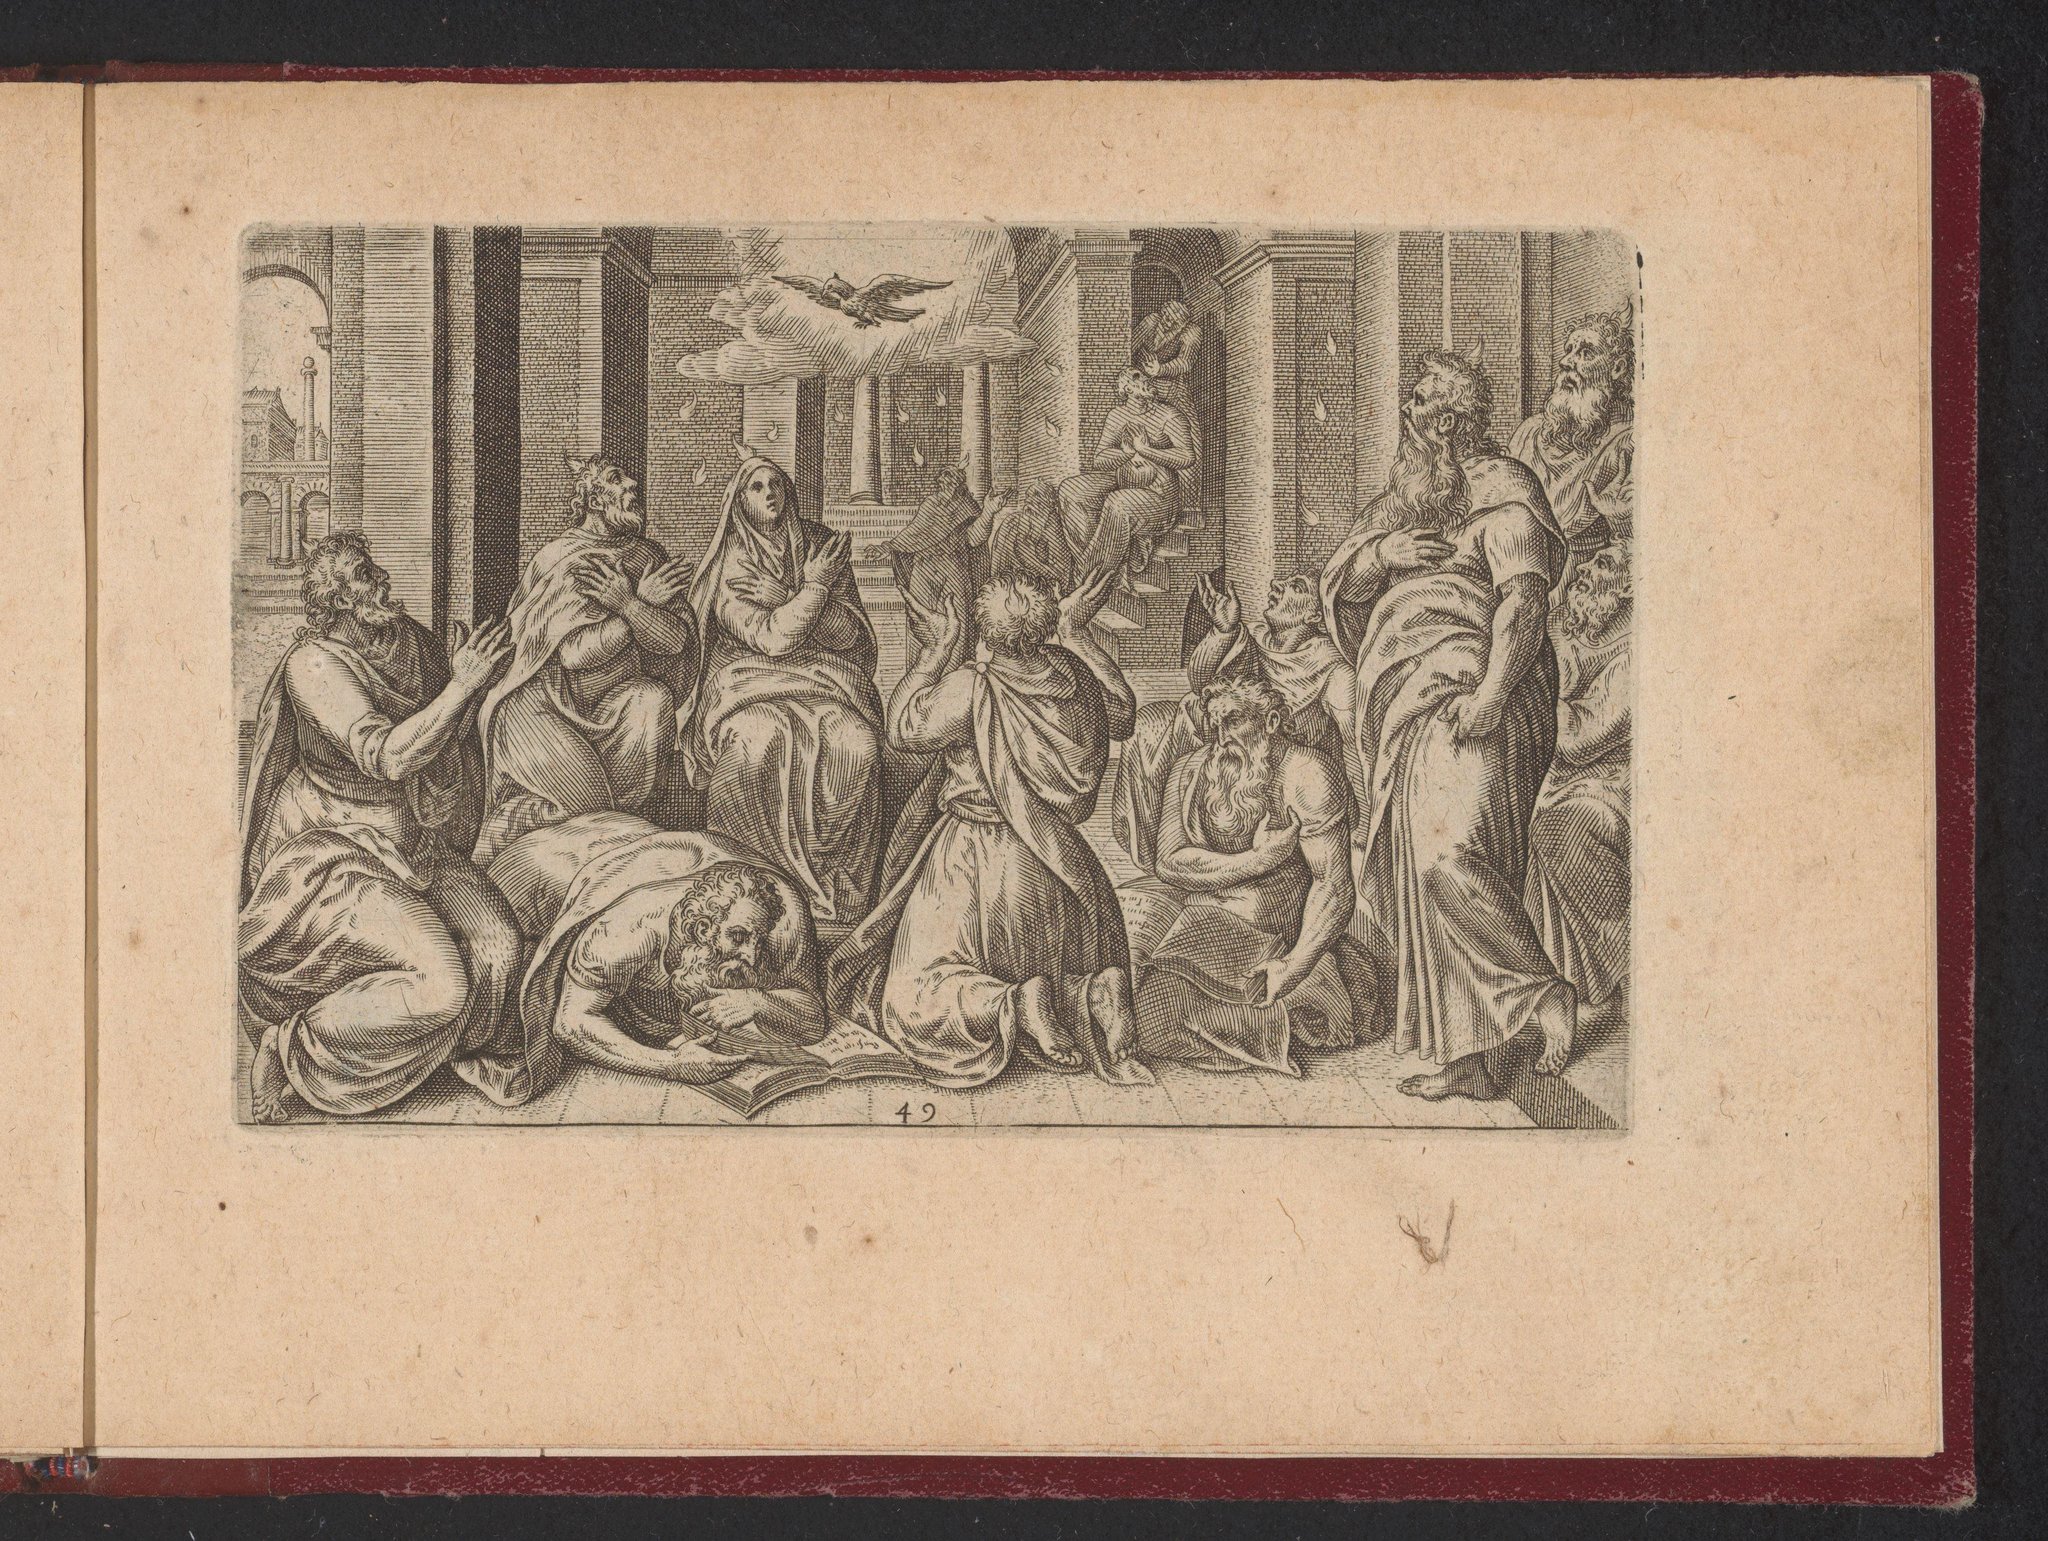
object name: print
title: Pinksteren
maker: philips galle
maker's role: print maker, publisher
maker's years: 1537-1612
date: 1573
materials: paper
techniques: engraving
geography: antwerp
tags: pentecost: the holy ghost descends upon (mary and) the apostles, sometimes paul and/or representatives of the nations present (acts 2:1-4)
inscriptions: watermark: ‘gotische letter P’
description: Onderdeel van een album met een titelprent en een serie van 50 prenten betreffende het leven en de passie van Christus.